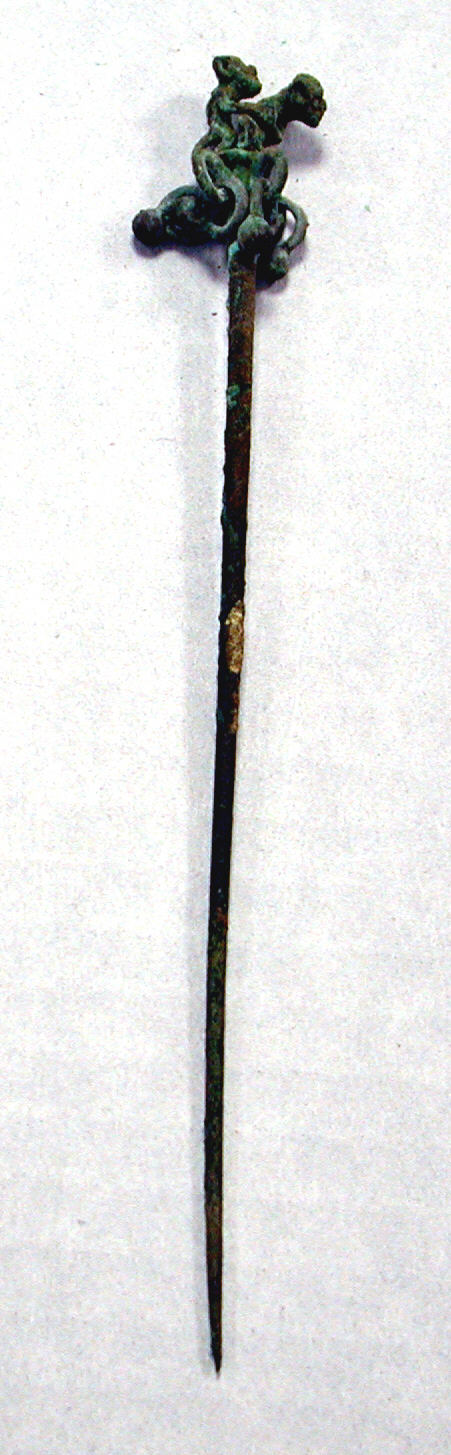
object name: knife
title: Ceremonial Knife (Tumi)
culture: chimú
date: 1101-1500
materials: copper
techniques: casting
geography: peru